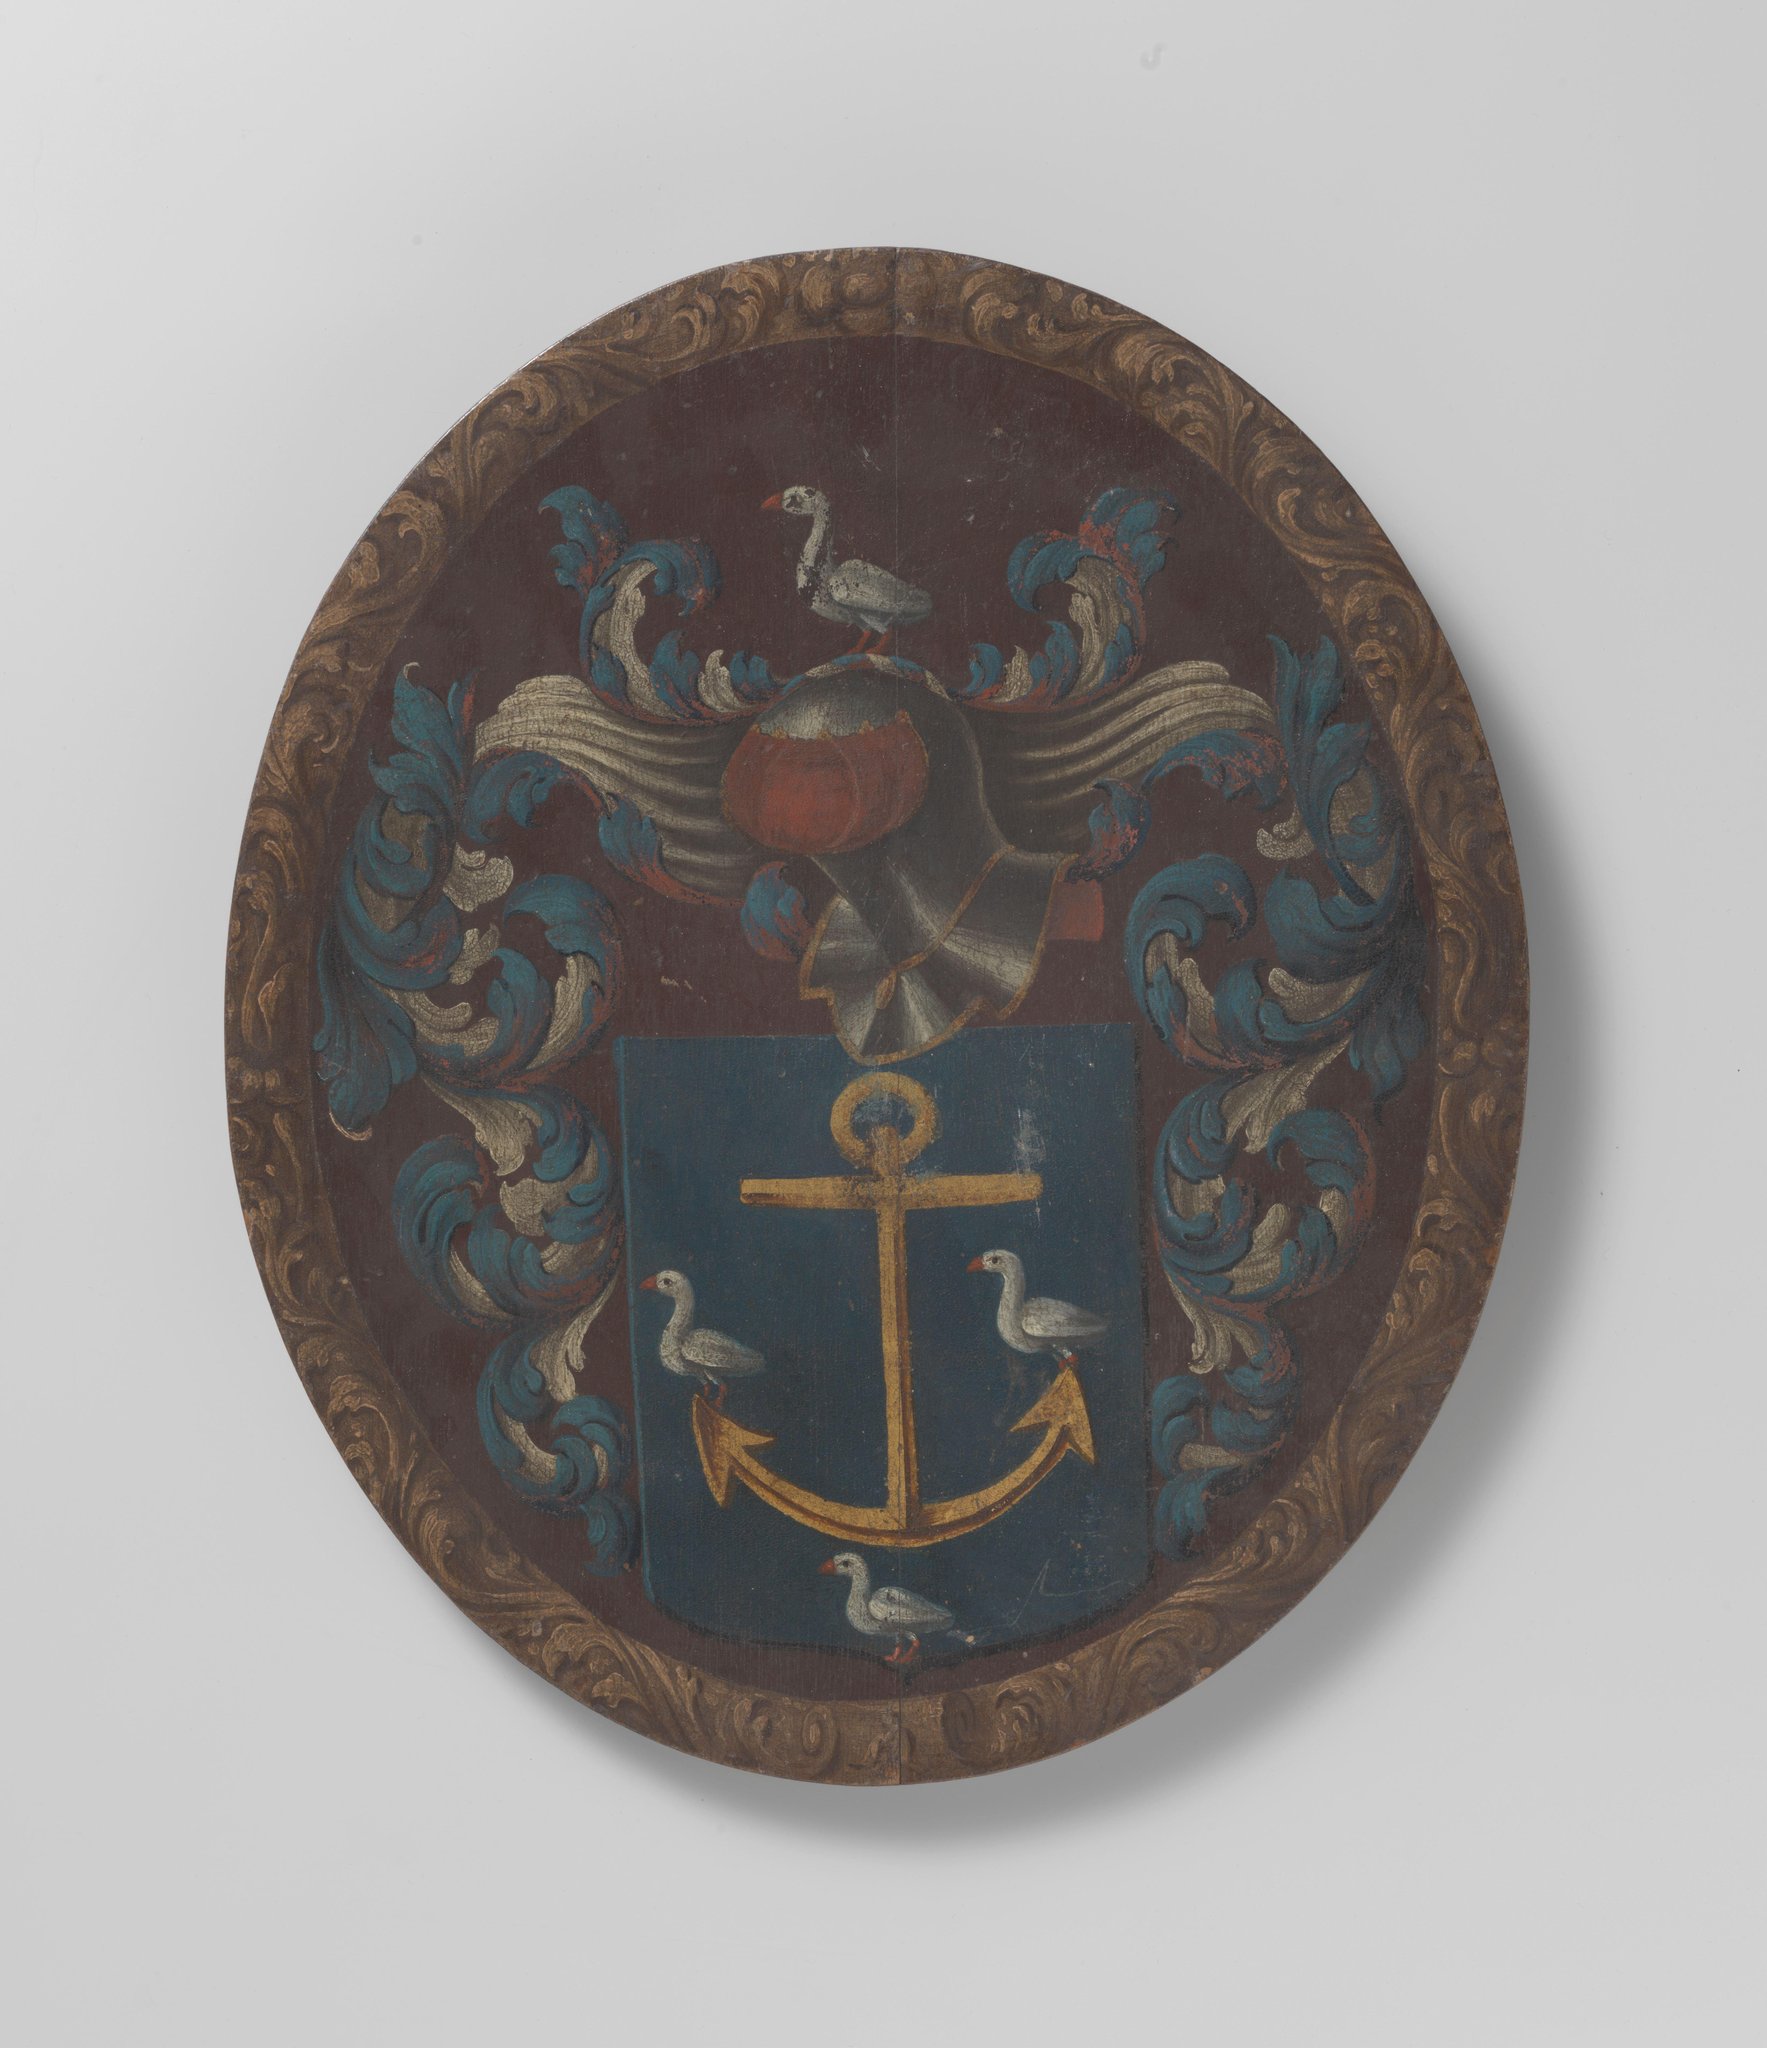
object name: wapenbord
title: Wapenbord met gouden anker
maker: Anonymous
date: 1881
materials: panel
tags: armorial bearing, heraldry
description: Ovaal houten wapenbord. Het wapen draagt een gouden anker en drie eenden op blauwe grond.